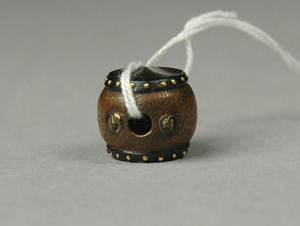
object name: ojime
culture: japanese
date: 1801-1900